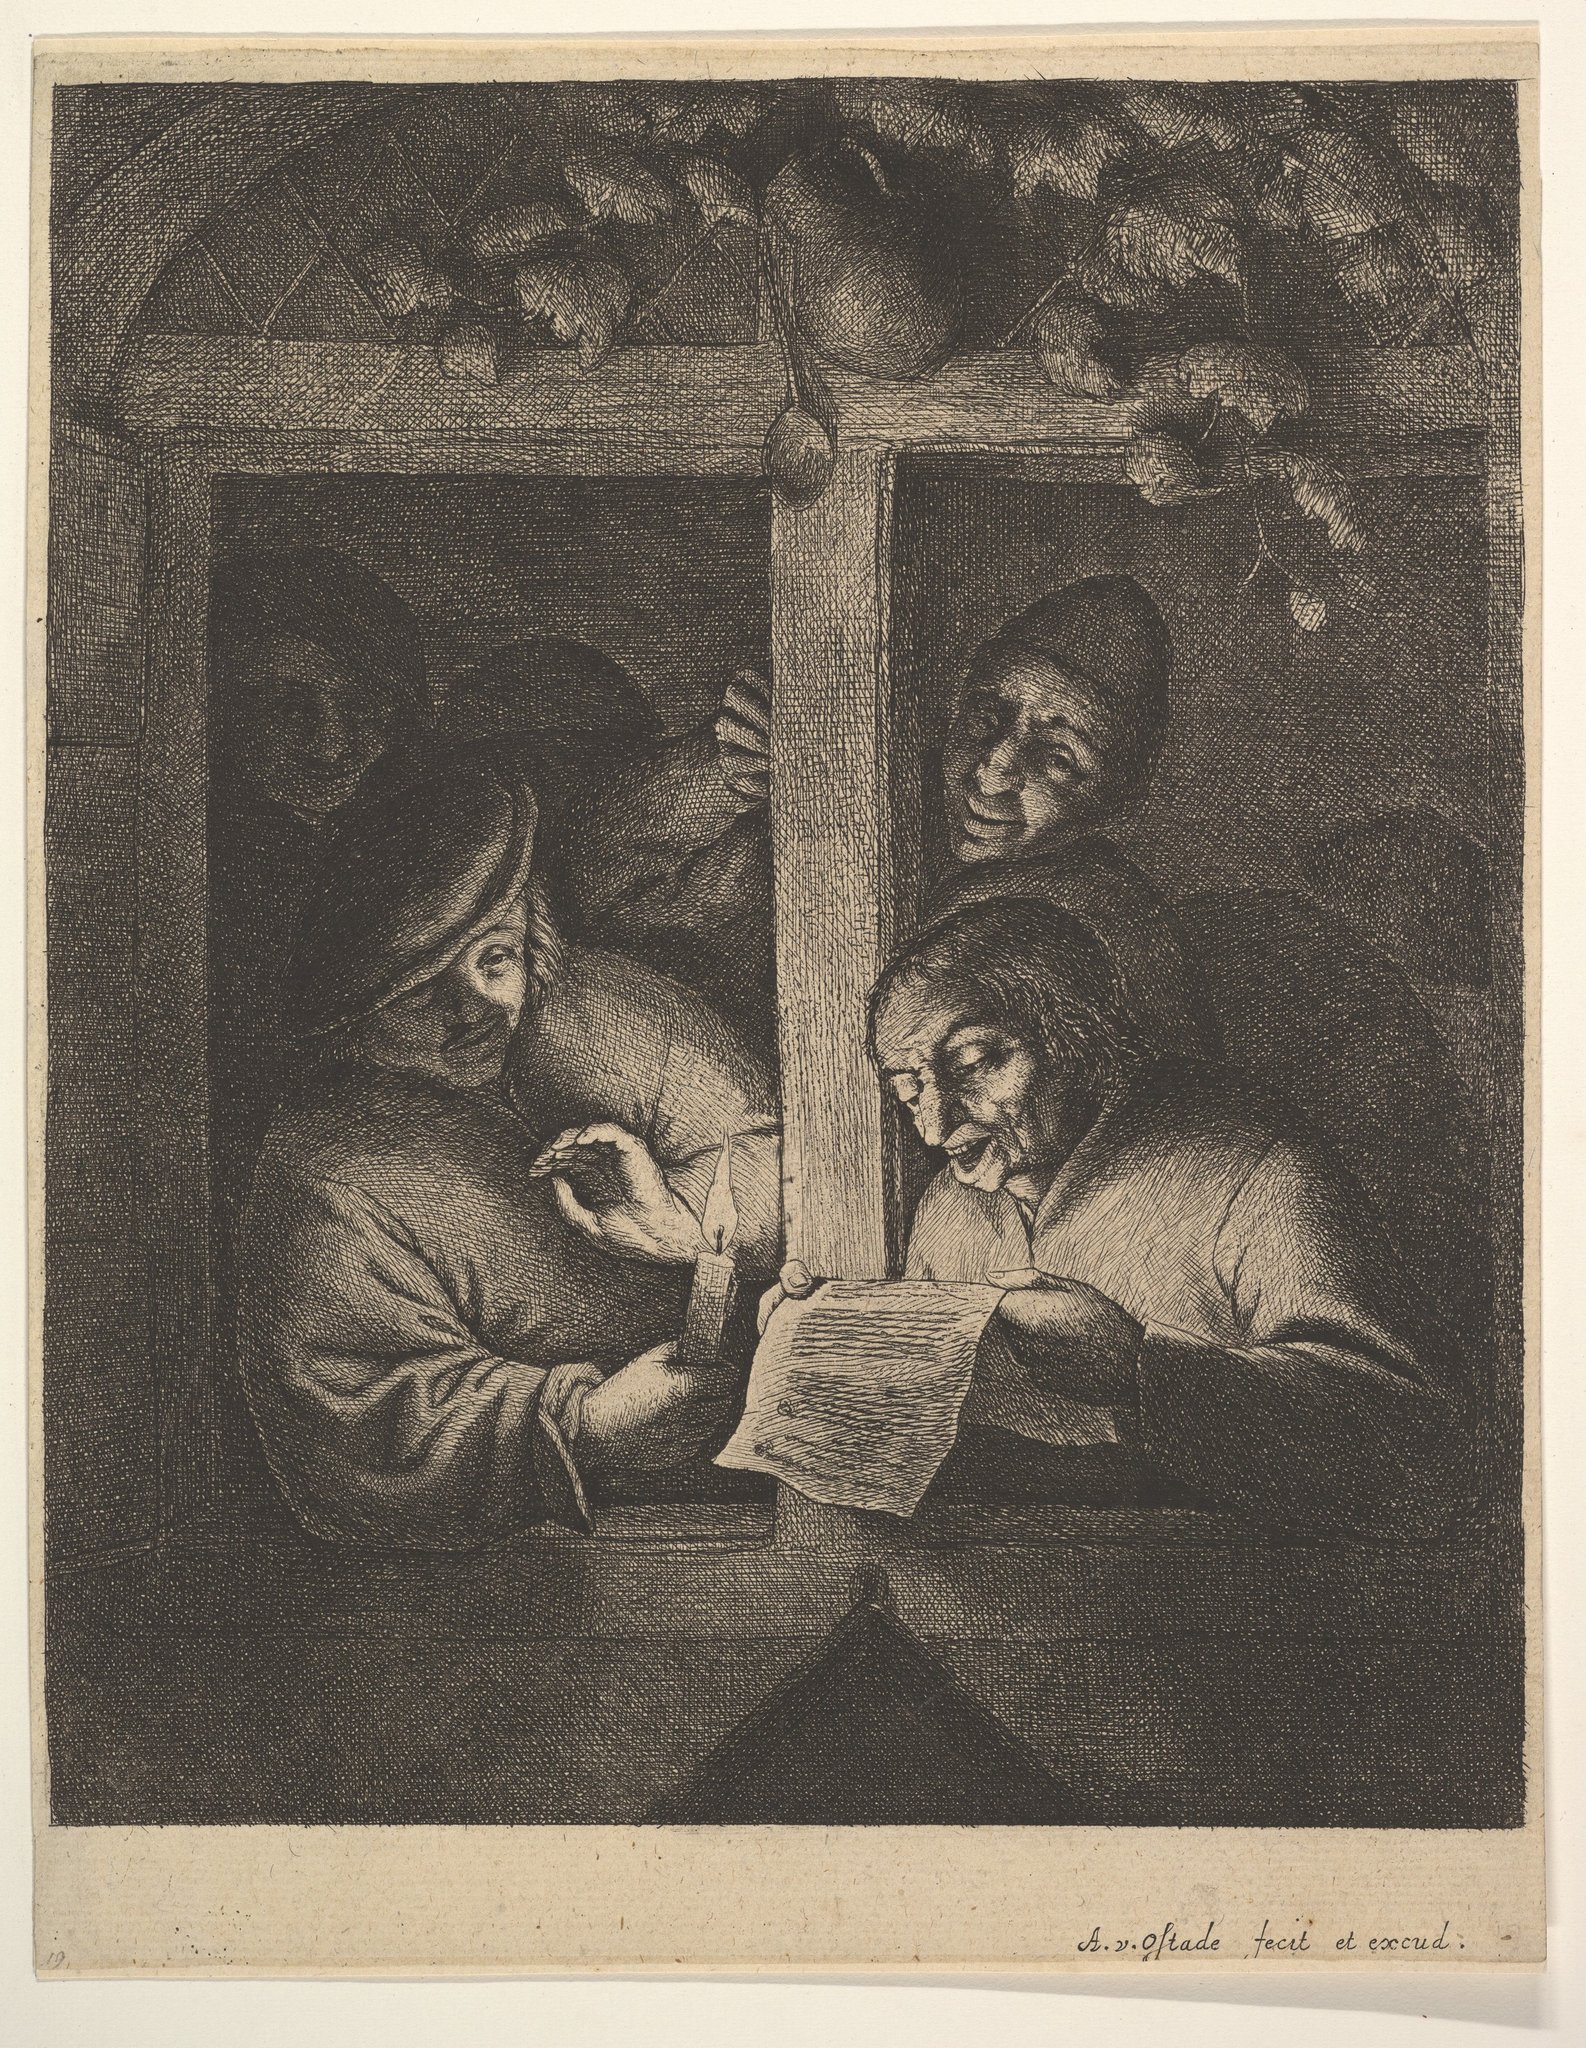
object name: print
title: Singers at the Window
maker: adriaen van ostade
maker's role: artist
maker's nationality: dutch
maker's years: 1610-1685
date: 1610-1685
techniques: etching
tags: windows,men,singers